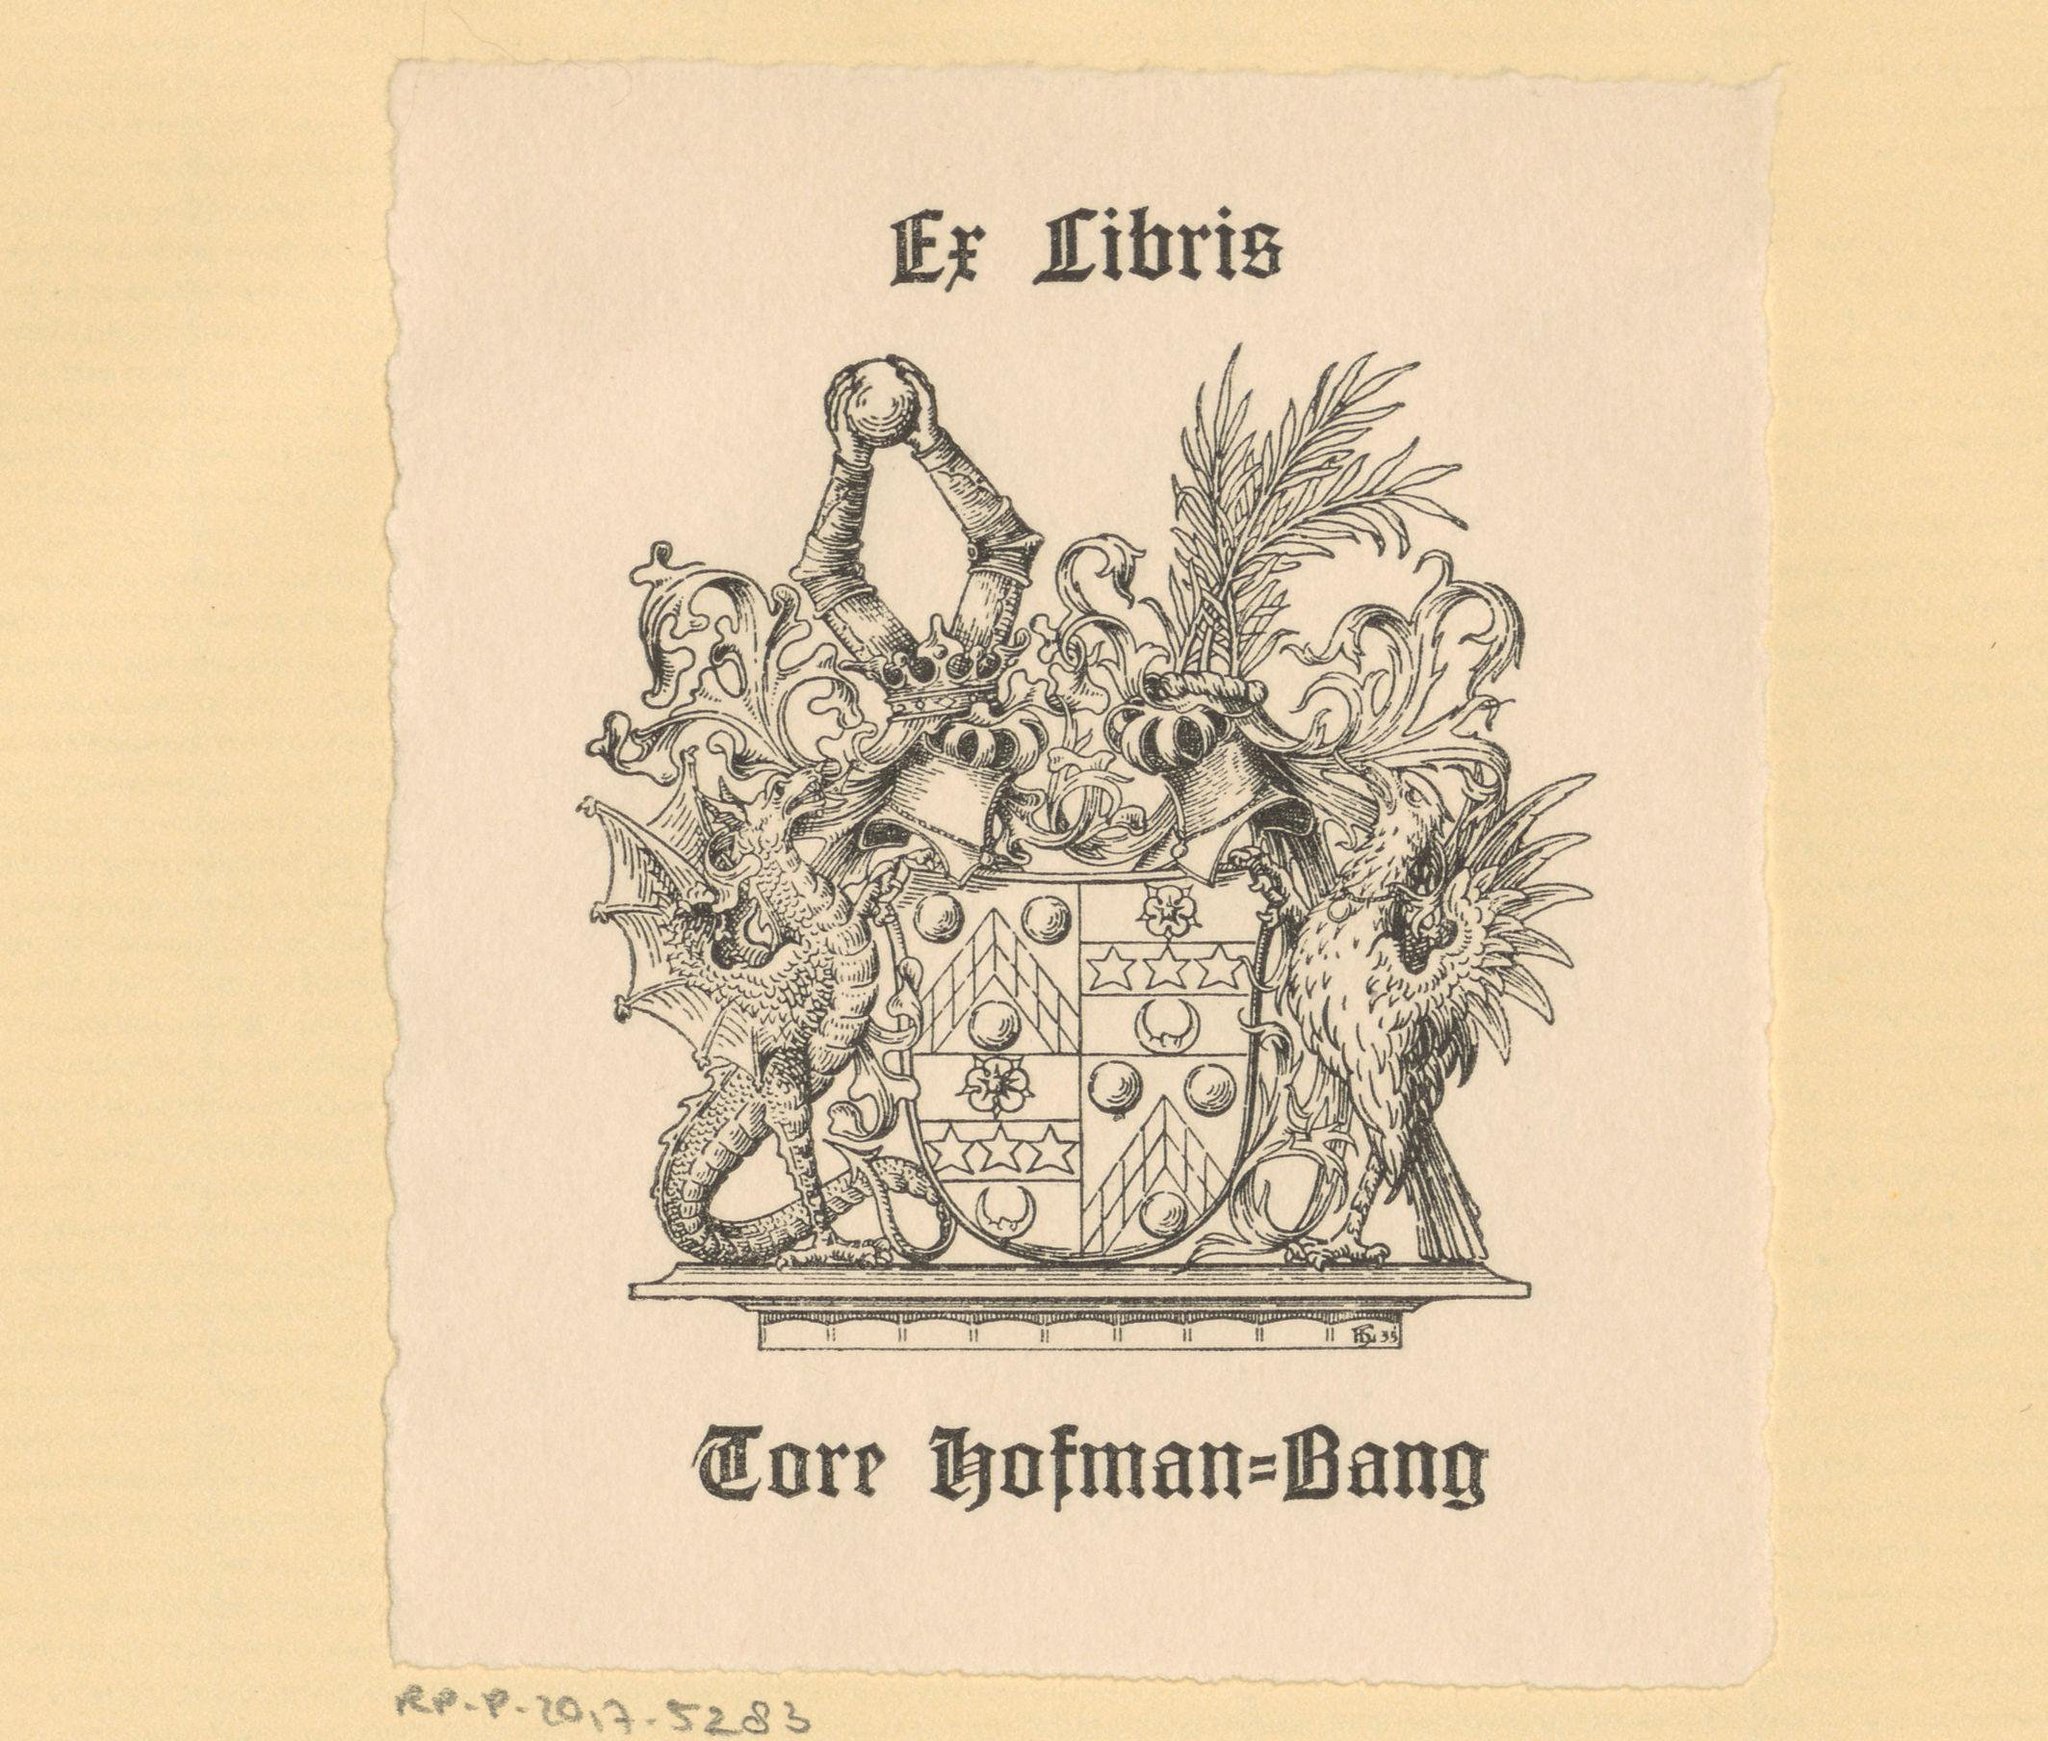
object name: bookplate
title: Ex libris van Tore Hofman-Bang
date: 1935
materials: paper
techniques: printing block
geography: germany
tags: predatory birds: eagle, dragon, armorial bearing, heraldry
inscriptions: date